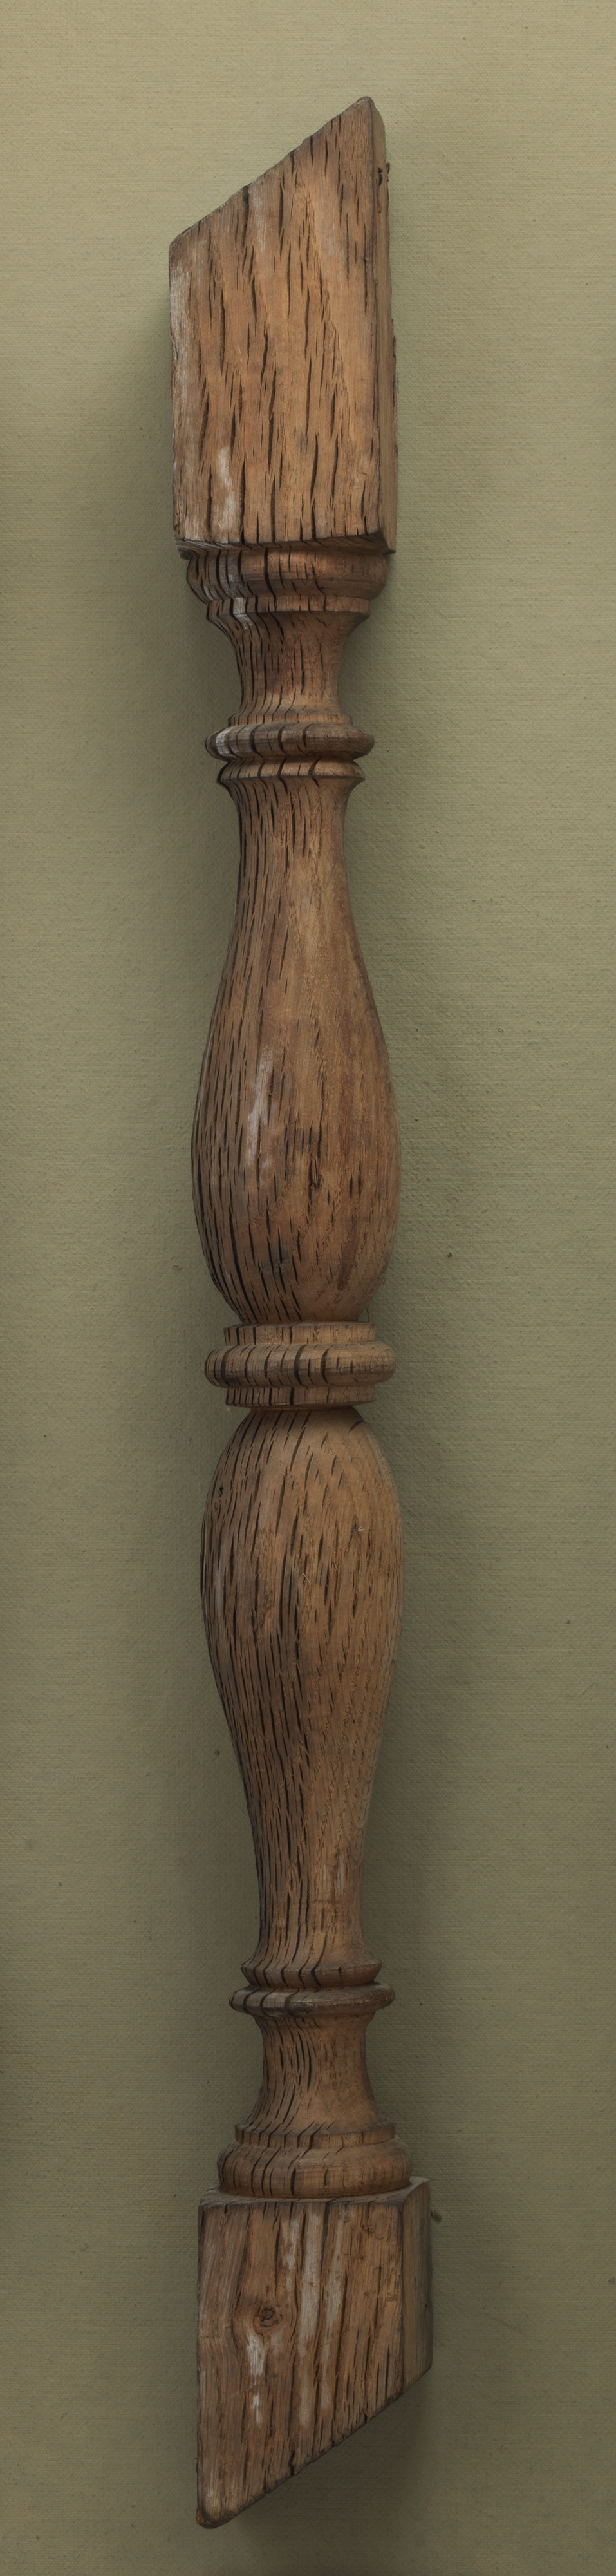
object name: baluster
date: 1701-1733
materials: wood